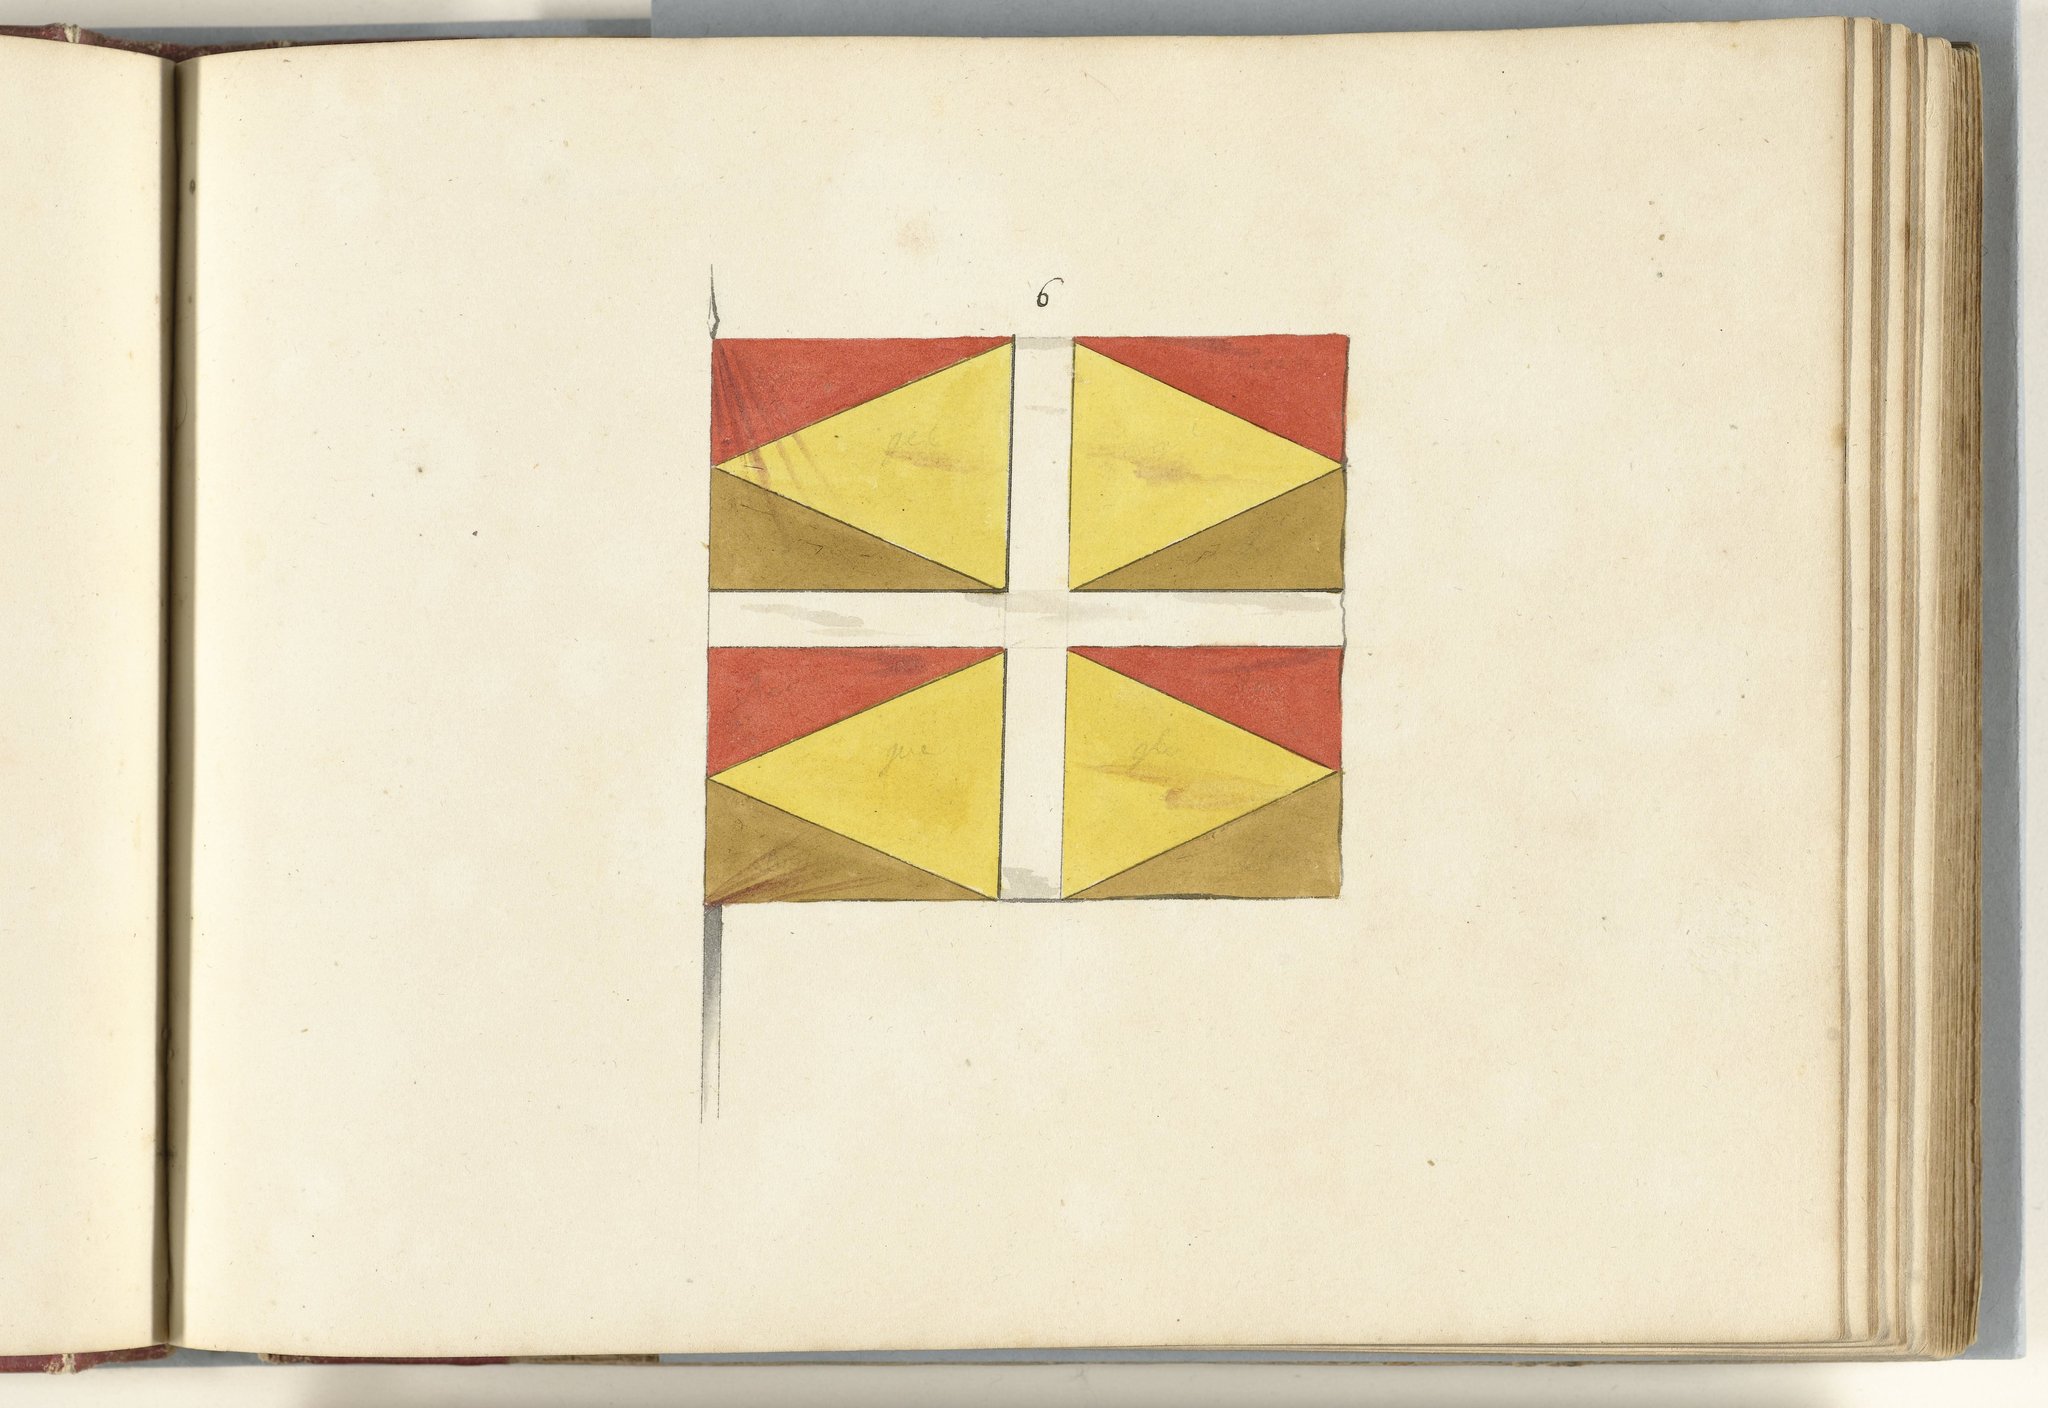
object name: drawing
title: Frans vaandel veroverd bij de slag bij Ramillies, 1706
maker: Anonymous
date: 1713-1720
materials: paper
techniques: drawing, writing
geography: northern netherlands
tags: (military) flags and standards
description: Frans vaandel veroverd bij de slag bij Ramillies 1706. In het boek met tekeningen van Franse vaandels, standaarden en pauken, veroverd tijdens de Spaanse Successieoorlog (1701-1713).